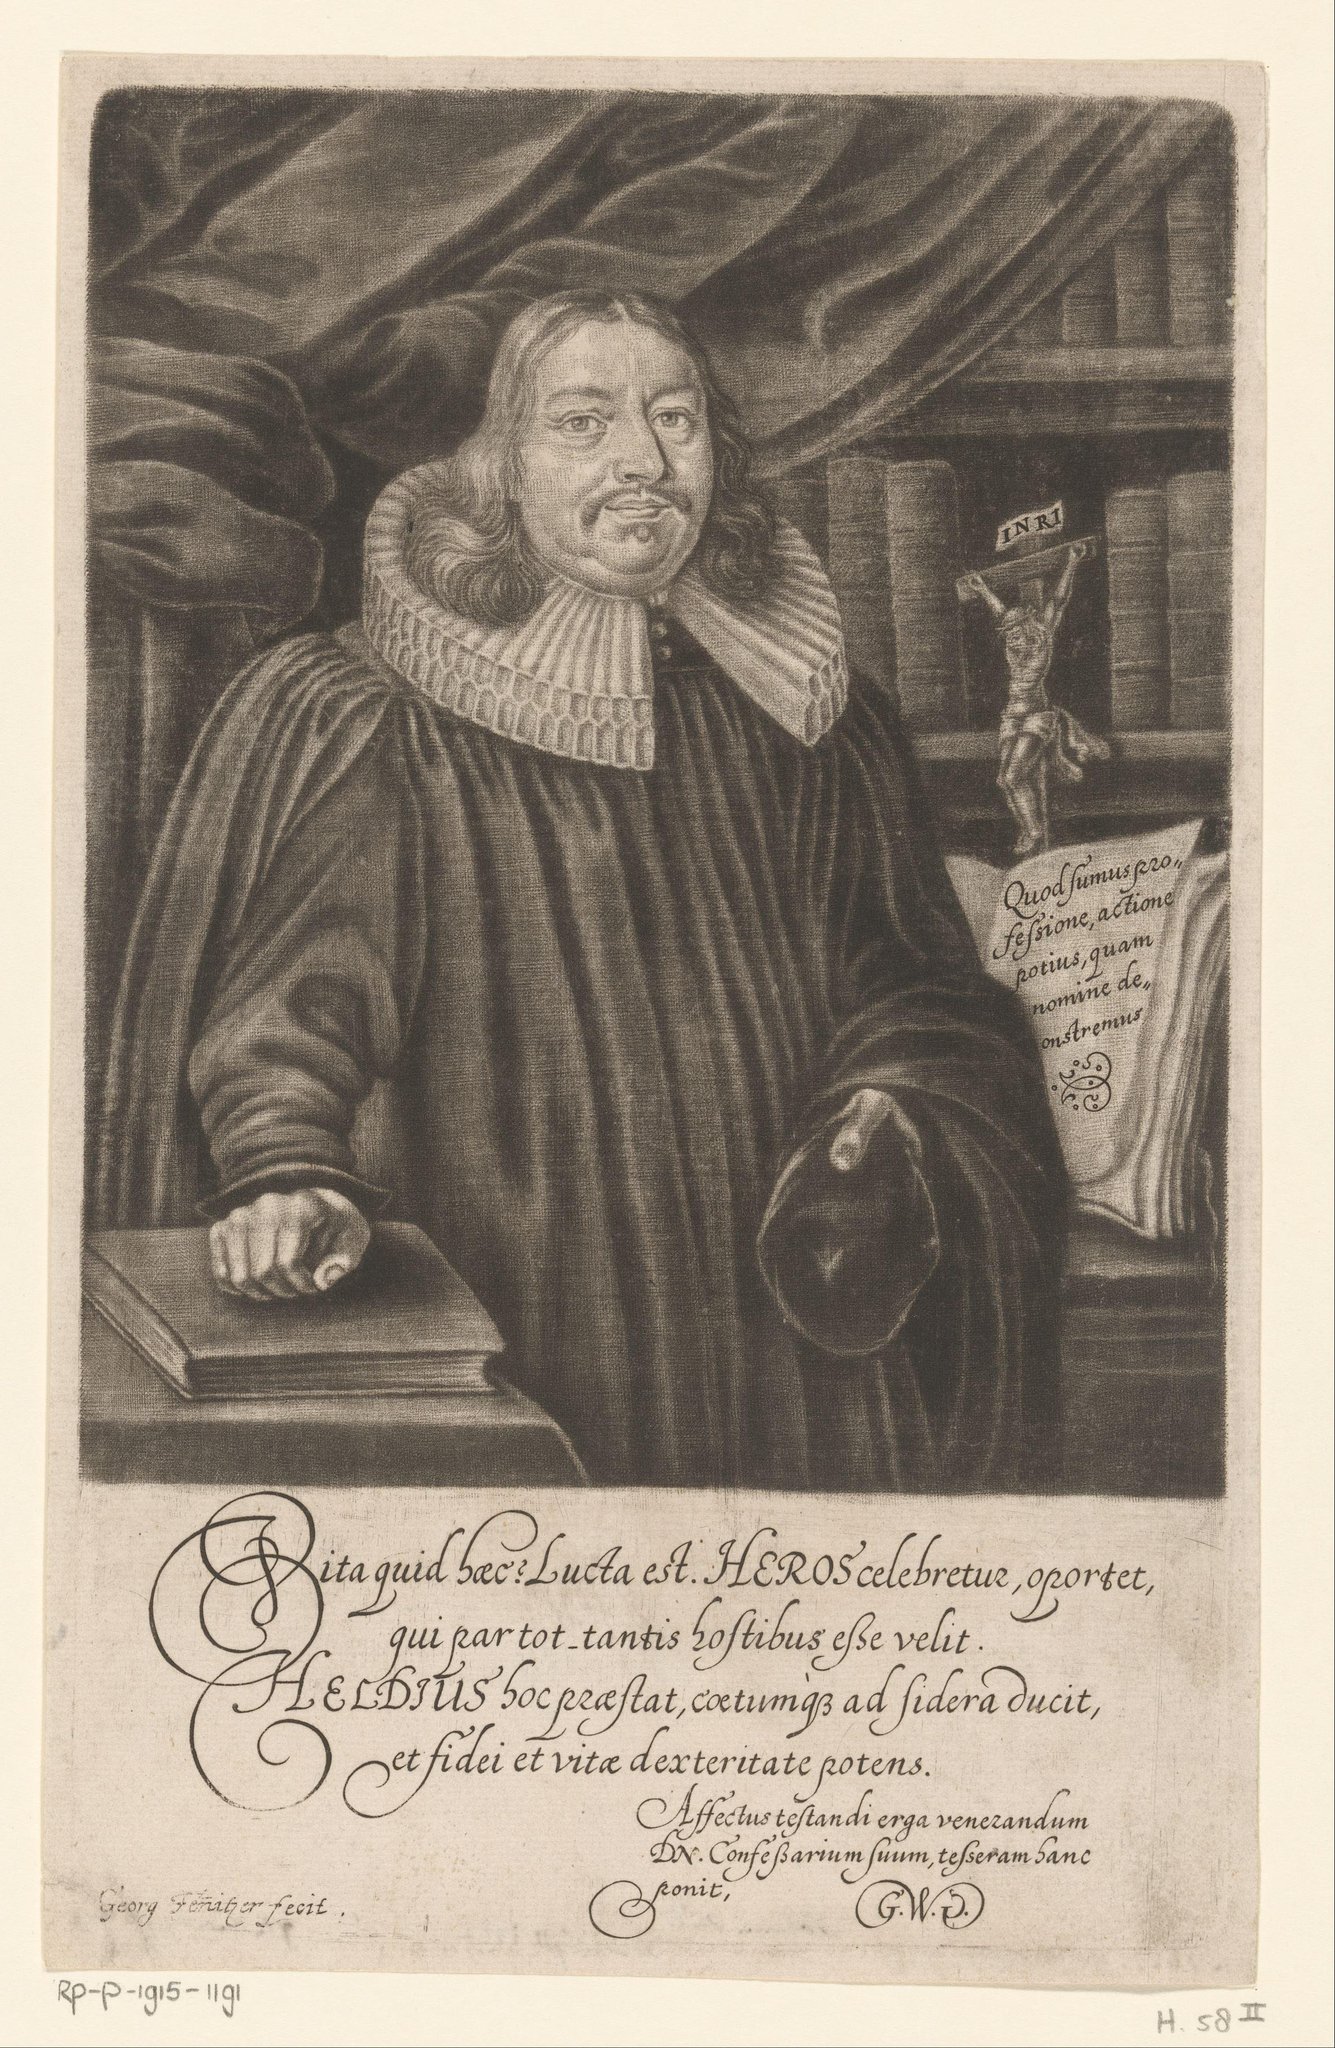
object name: print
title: Portret van Johann Held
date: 1656-1722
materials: paper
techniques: etching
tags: bookshelves, historical persons, deacon (roman catholic), book, crucifix ~ personal devotion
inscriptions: collector's mark: Lugt 2228, inscription